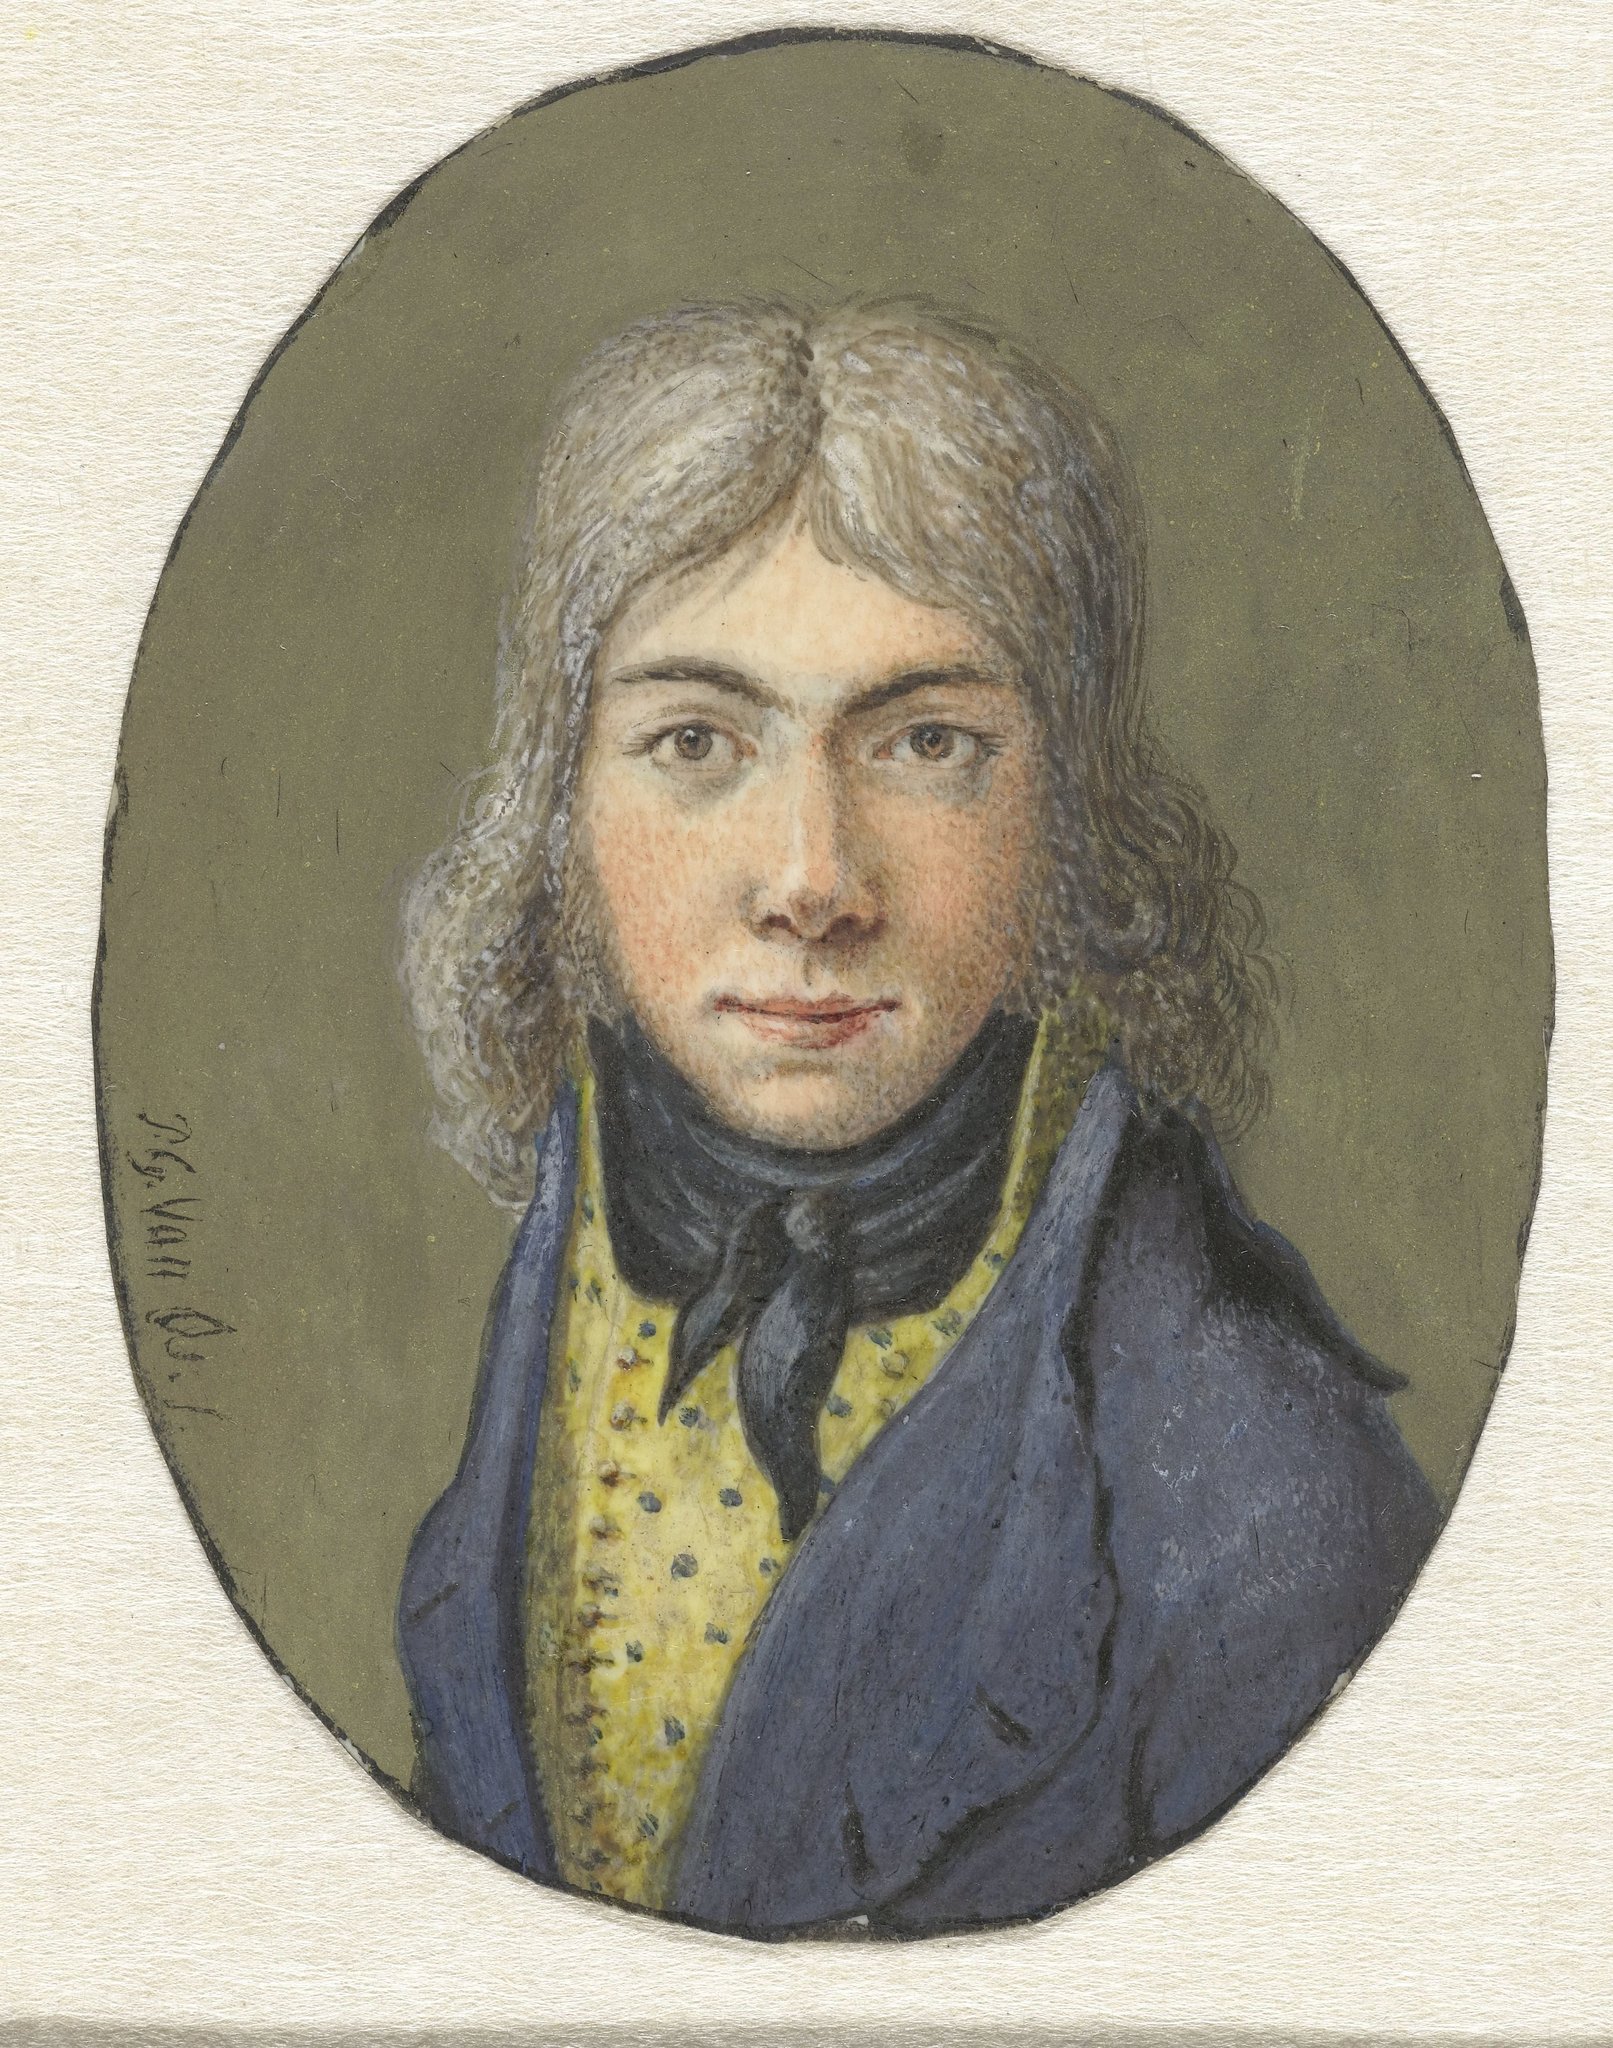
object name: drawing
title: Portret van een jonge man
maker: pieter gerardus van os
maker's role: draughtsman, painter, print maker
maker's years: 1776-1839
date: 1786-1839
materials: paint, gouache, ivory, watercolor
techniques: brush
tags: anonymous historical person portrayed alone